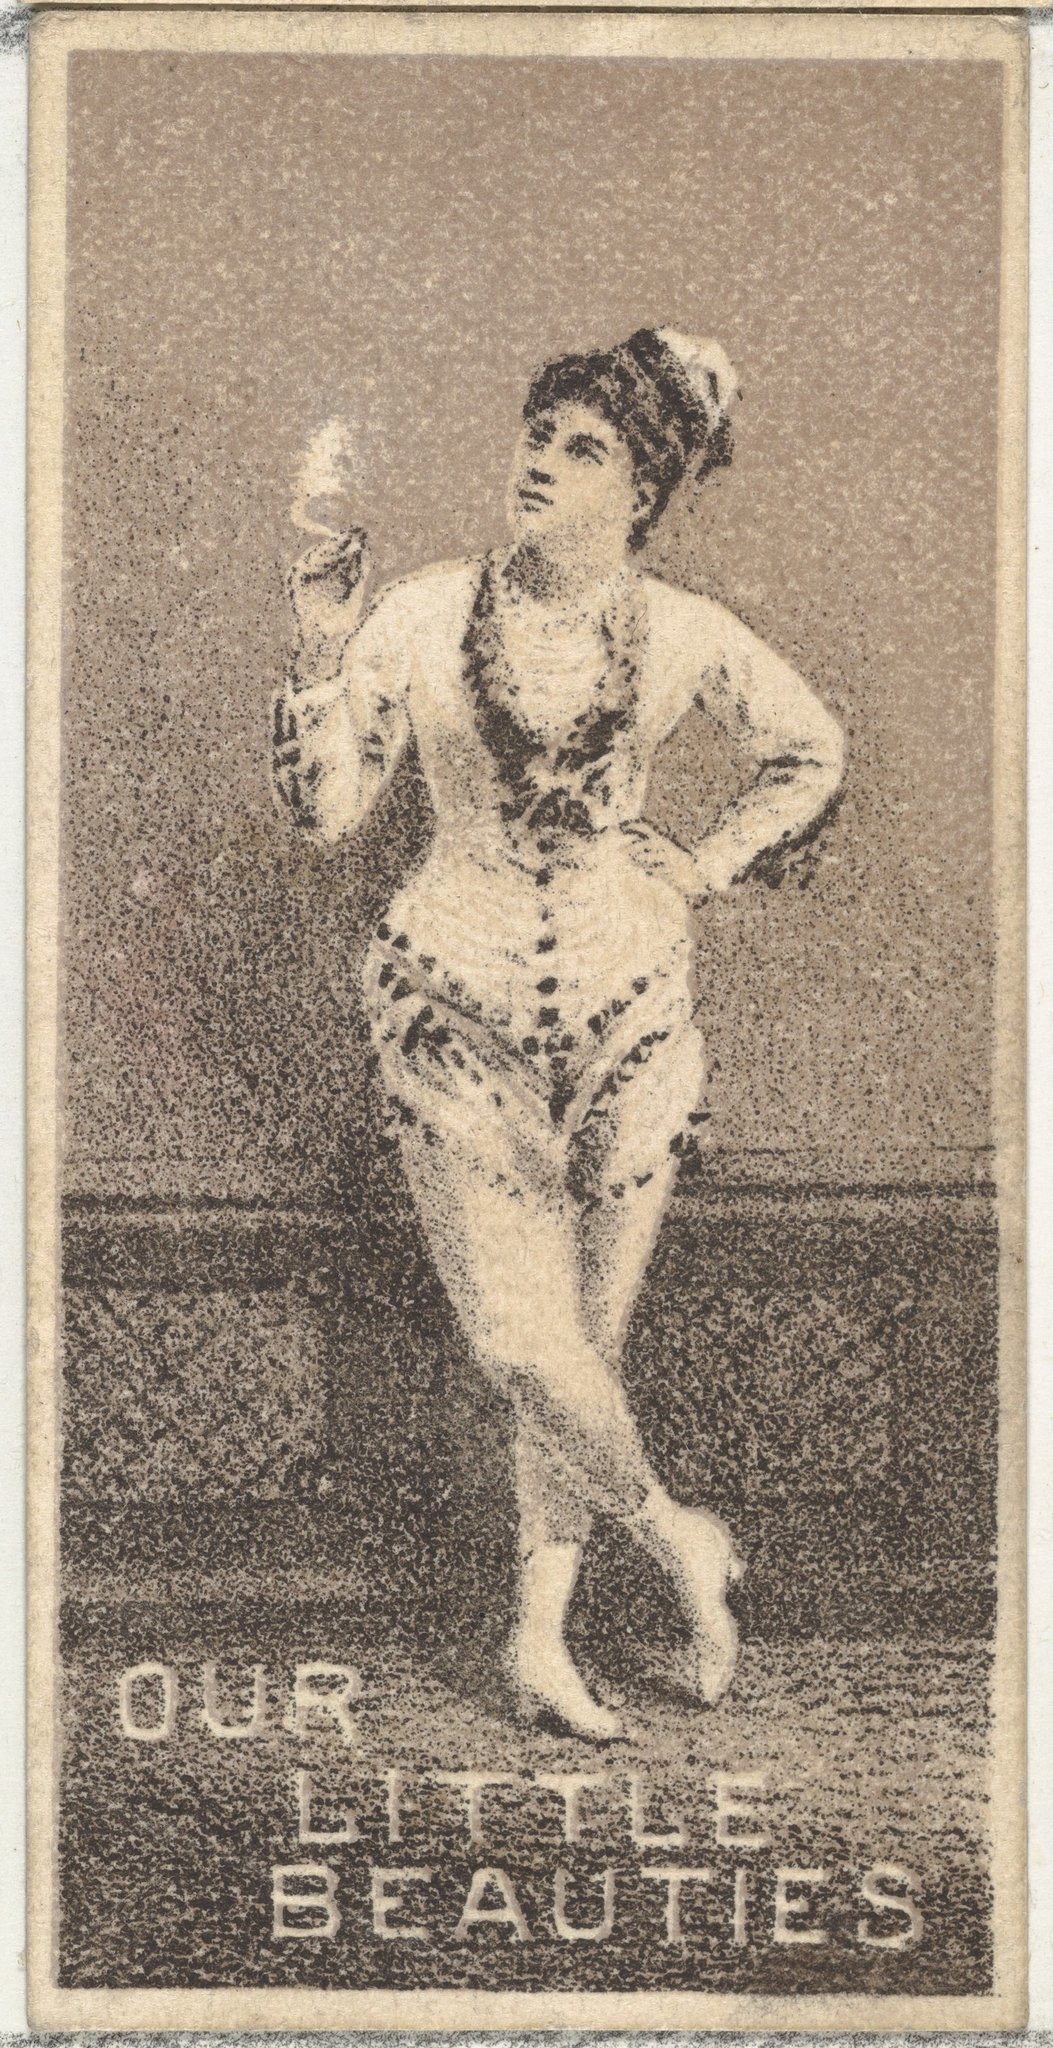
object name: print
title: From the Actresses series (N57) promoting Our Little Beauties Cigarettes for Allen & Ginter brand tobacco products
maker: allen & ginter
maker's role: publisher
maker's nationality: american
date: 1890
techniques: photolithograph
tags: portraits,women,actresses